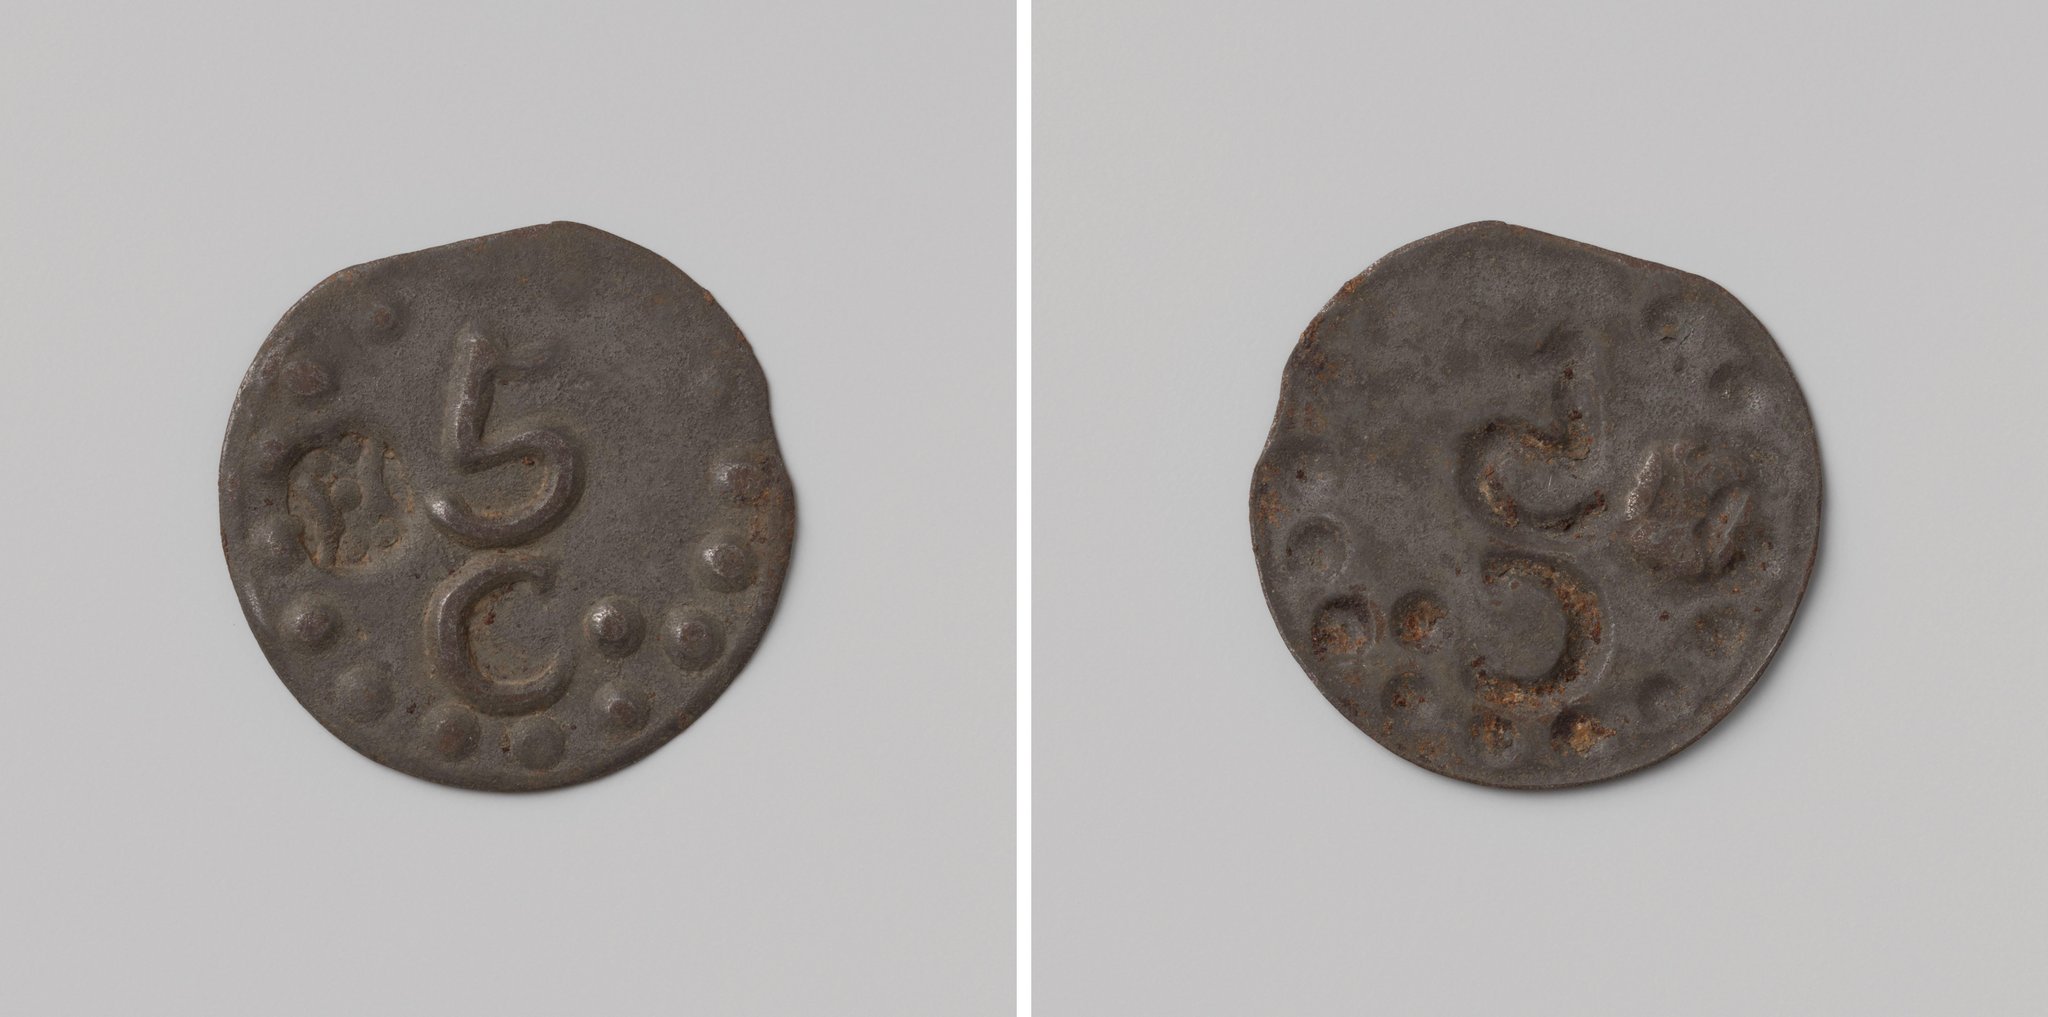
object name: vijf cent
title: Strafgevangenis Ommerschans, huismunt geslagen op last van de Maatschappij van Weldadigheid ter waarde van vijf cent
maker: Anonymous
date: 1822-1830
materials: metal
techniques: striking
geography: ommerschans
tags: maatschappij van weldadigheid, ommerschans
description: Eenzijdige munt. Voorzijde: waardeaanduiding binnen parelrand; links: merk. Keerzijde: blanco.